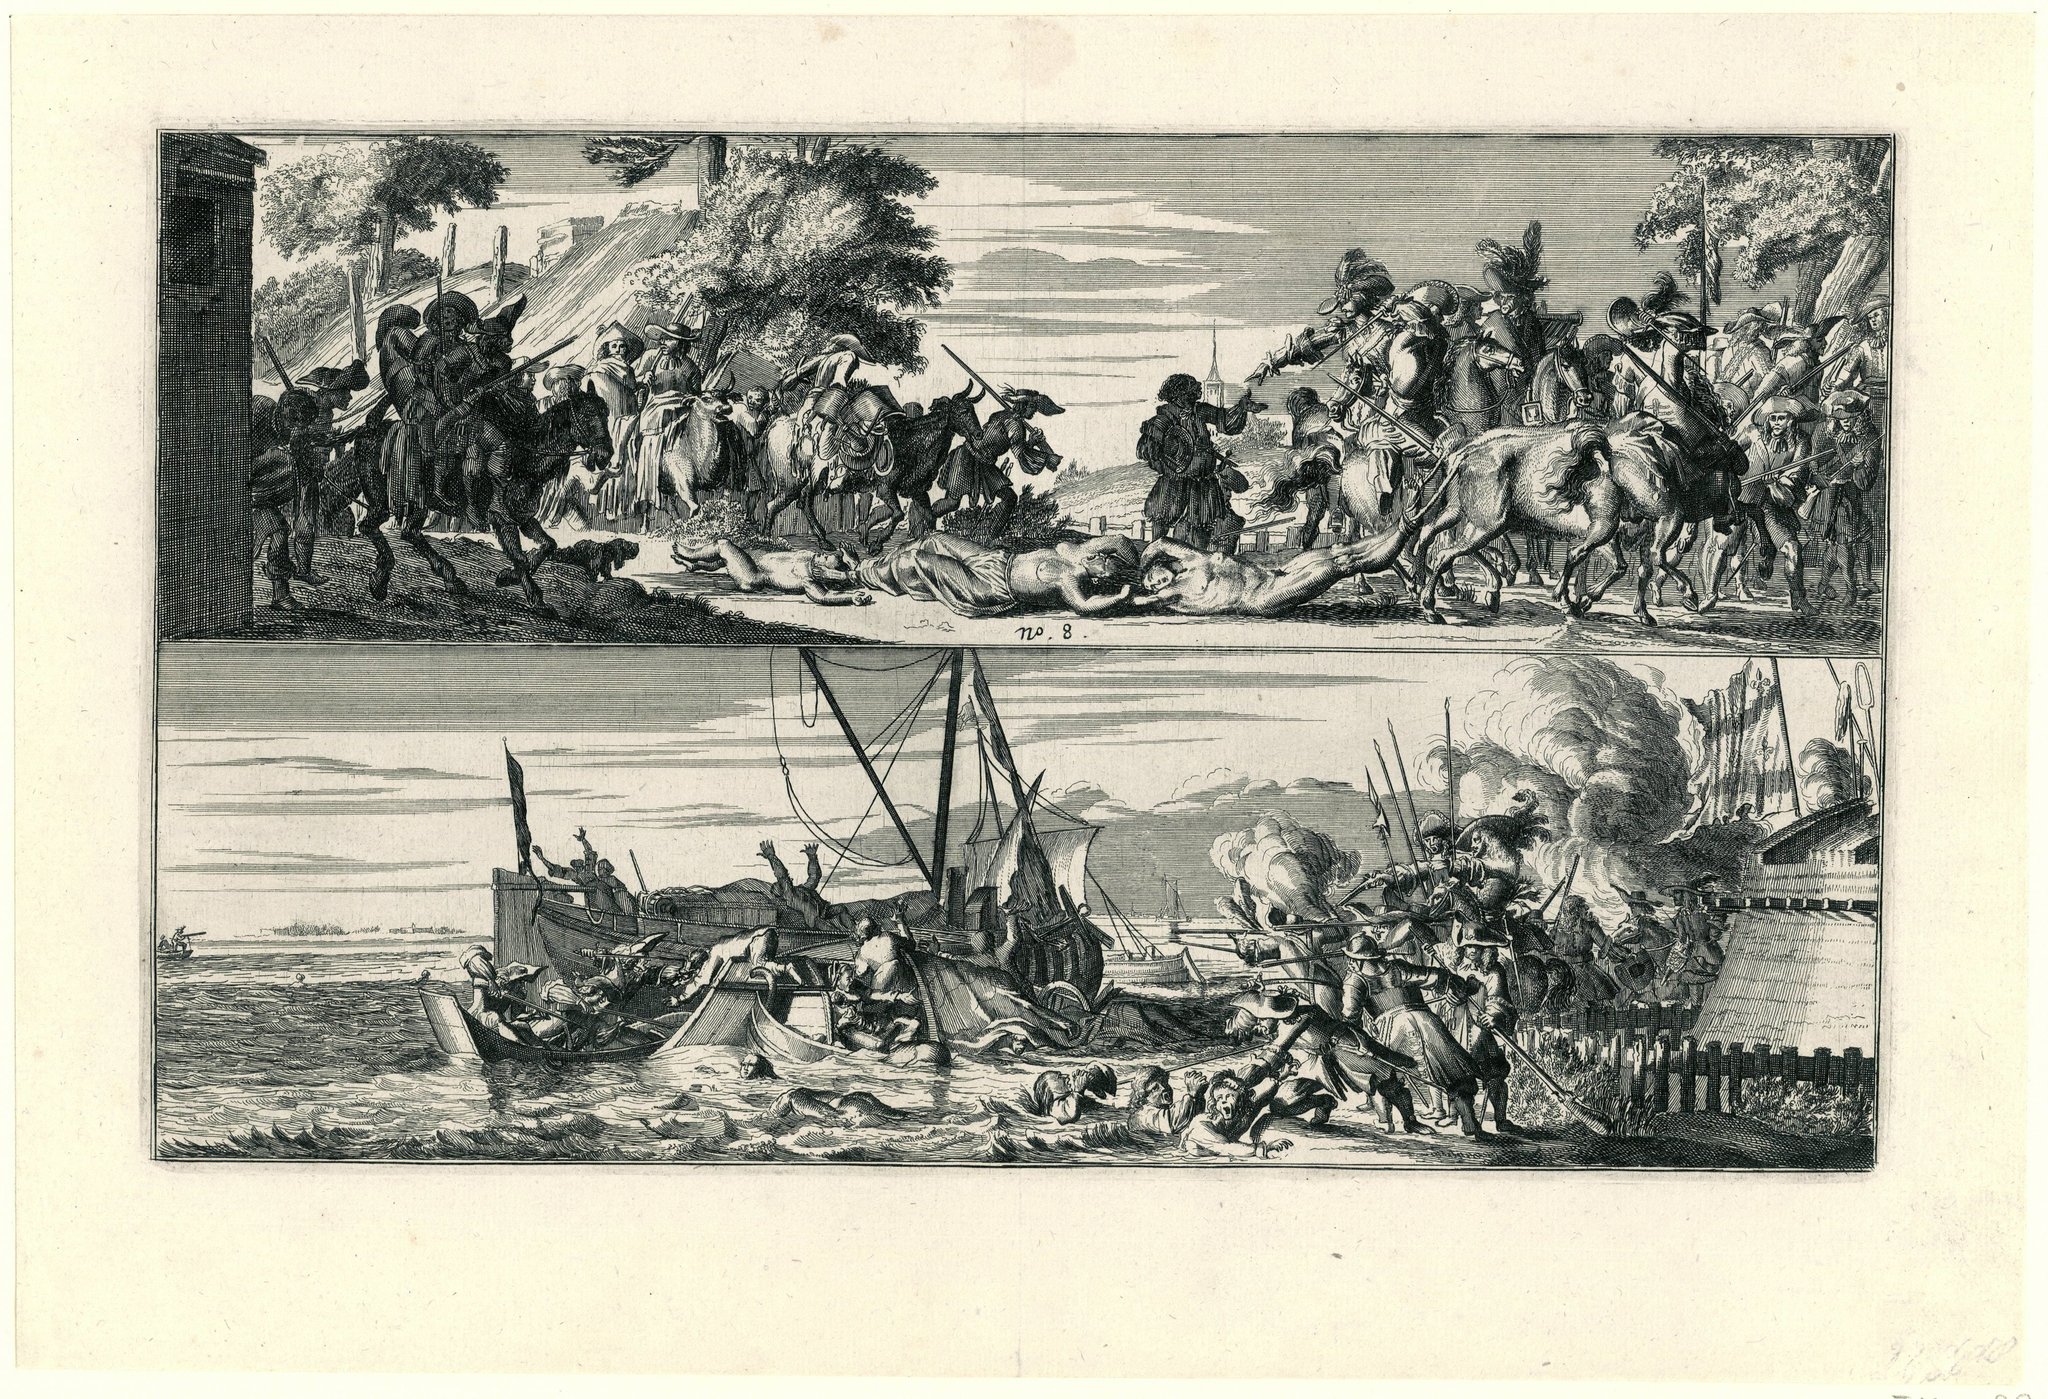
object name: print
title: Twee voorstellingen van Franse wreedheden, 1672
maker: Anonymous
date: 1673-1677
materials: paper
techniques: engraving, etching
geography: northern netherlands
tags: violent death, being killed; being mishandled and maltreated; seeking death, massacre ~ war, bodegraven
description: Prent ook gebruikt in: Bosch, Lambert van den. Toneel des oorlogs, opgerecht in de Vereenigde Nederlanden; door de wapenen van de koningen van Vrankrijk en Engeland, Keulsche en Munstersche […]. 4 delen. Amsterdam: Jacob van Meurs en Johannes van Someren, 1675, dl. 3, p. 52. En in: Valckenier, Peter en Andreas Muller. Das verwirrte Europa […]. 3 delen. Amsterdam: Hendrik en Dirk Boom, Joannes van Someren en Jacob van Meurs, 1677-1683, dl. 1 (1677), p. 432. Deze prent is gekopieerd naar een prent van Romeyn de Hooghe (RP-P-OB-77.200). Die prent is gebruikt in: Wicquefort, Abraham van. Avis fidelle aux veritables hollandois. Touchant ce qui s’est passé dans les villages de Bodegrave & Swammerdam, & les cruautés inoüies, que les françois y ont exercées […]. S.l. [Den Haag]: s.n.[Daniel en Johannes Steucker], 1673.